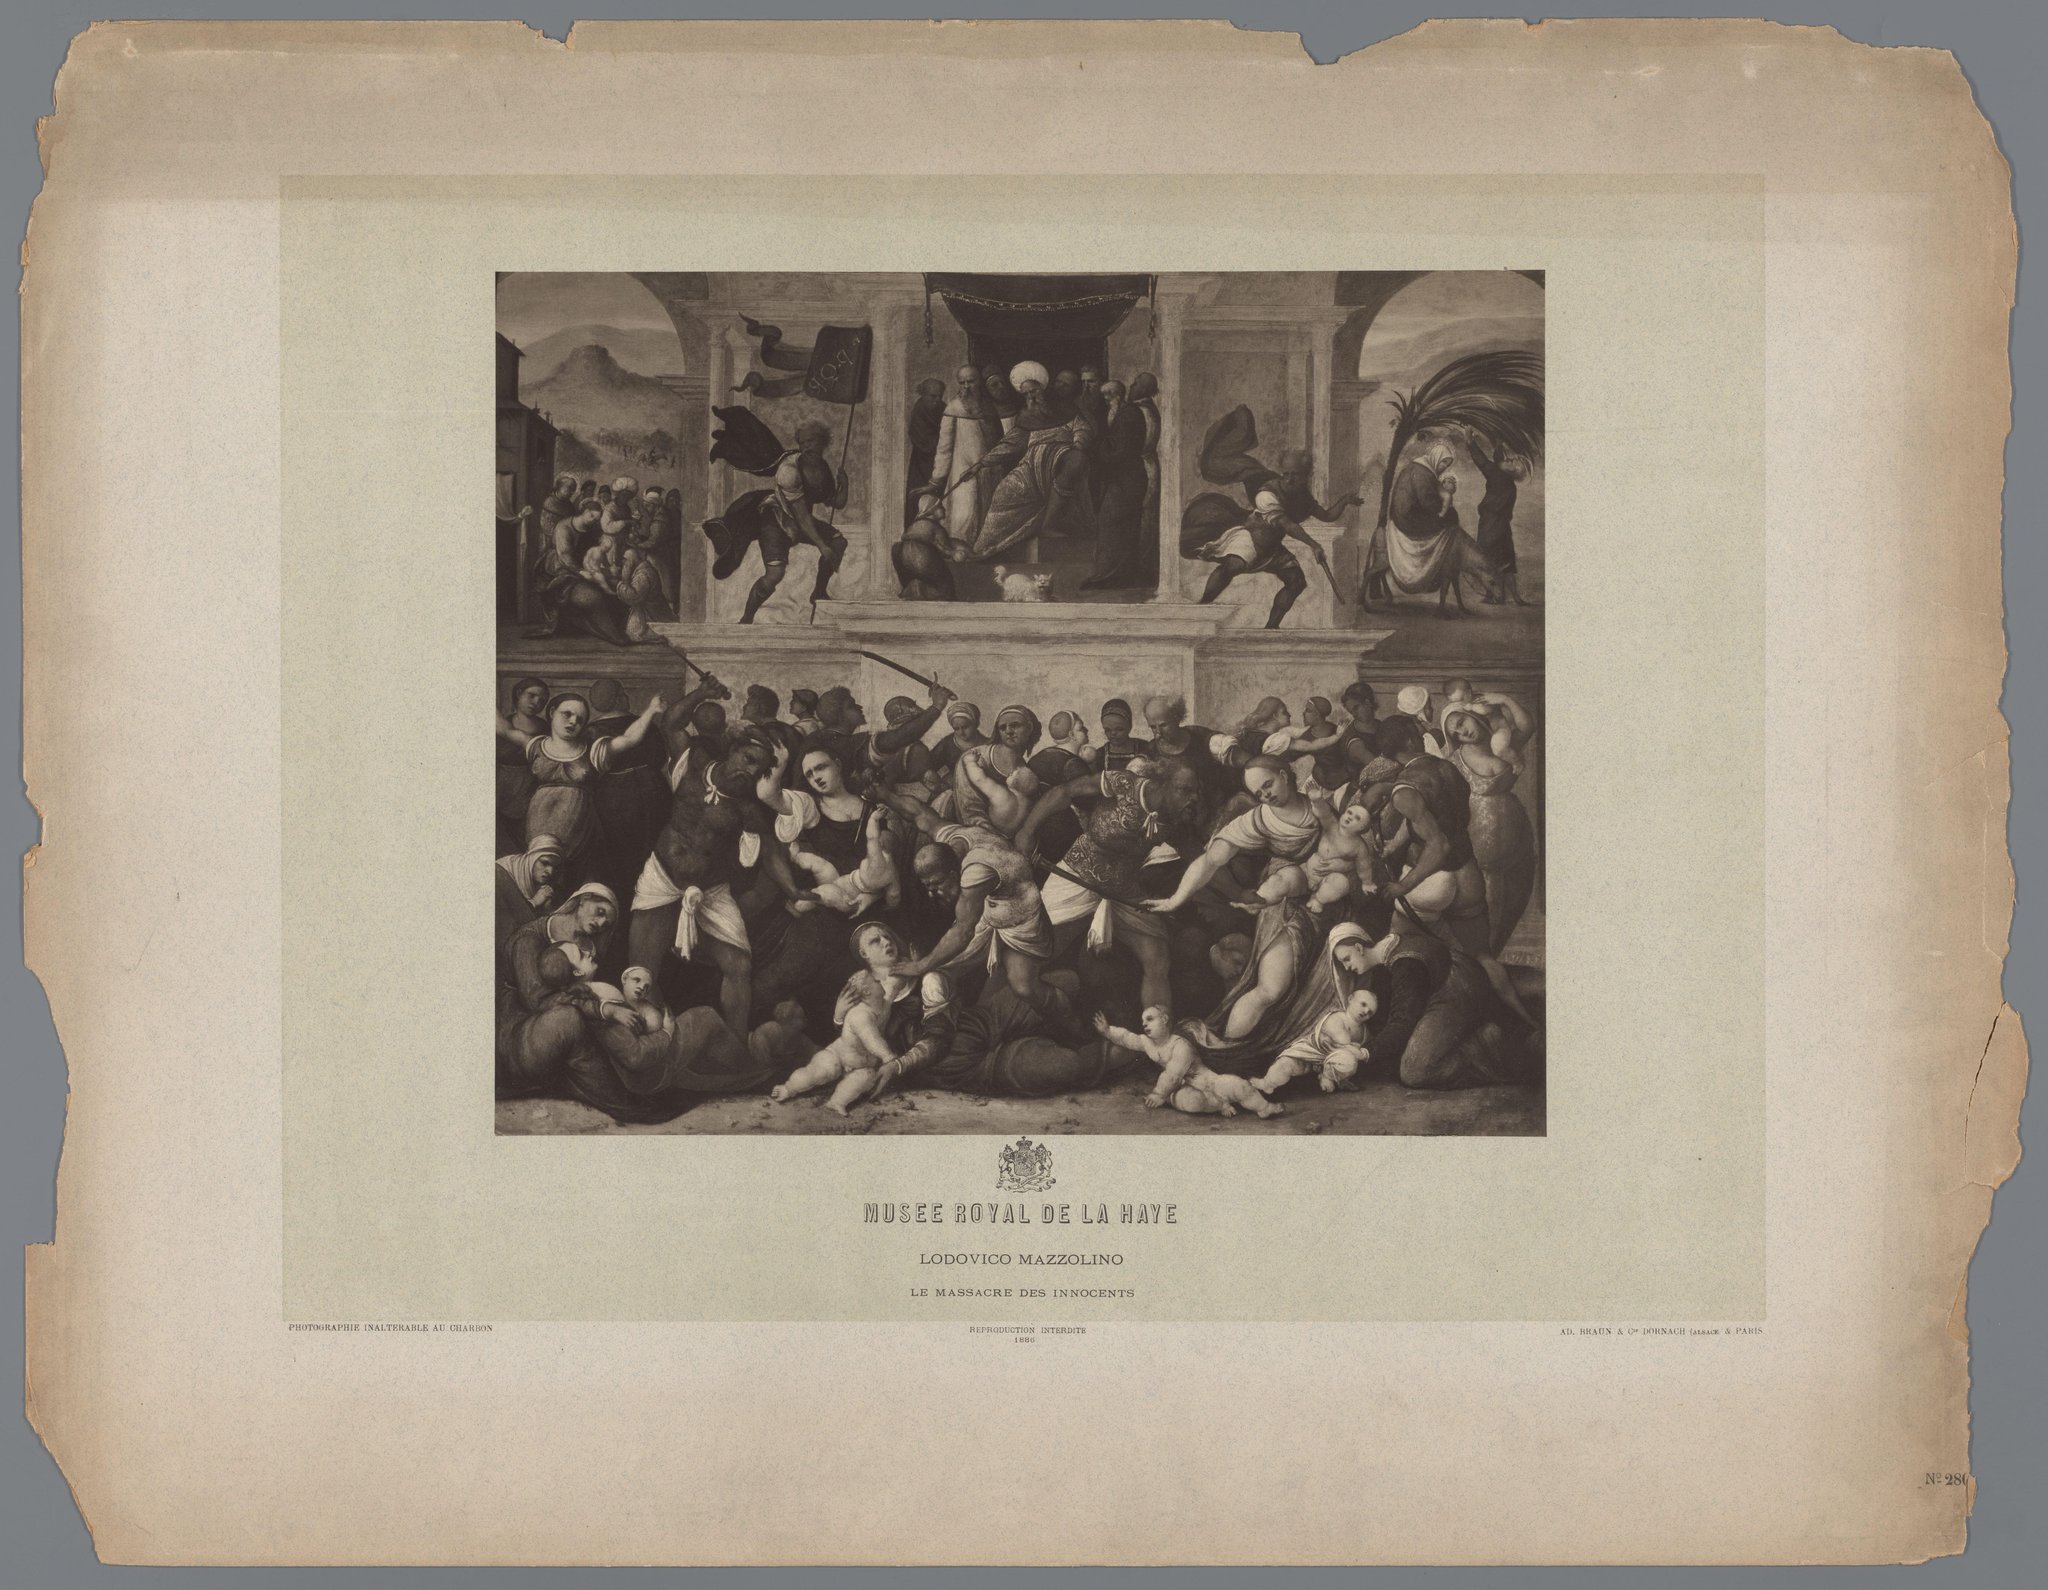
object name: photograph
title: Fotoreproductie van een schilderij van Lodovico Mazzolino, 'De kindermoord' (coll. Mauritshuis)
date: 1886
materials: cardboard, paper, photographic support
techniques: carbon print